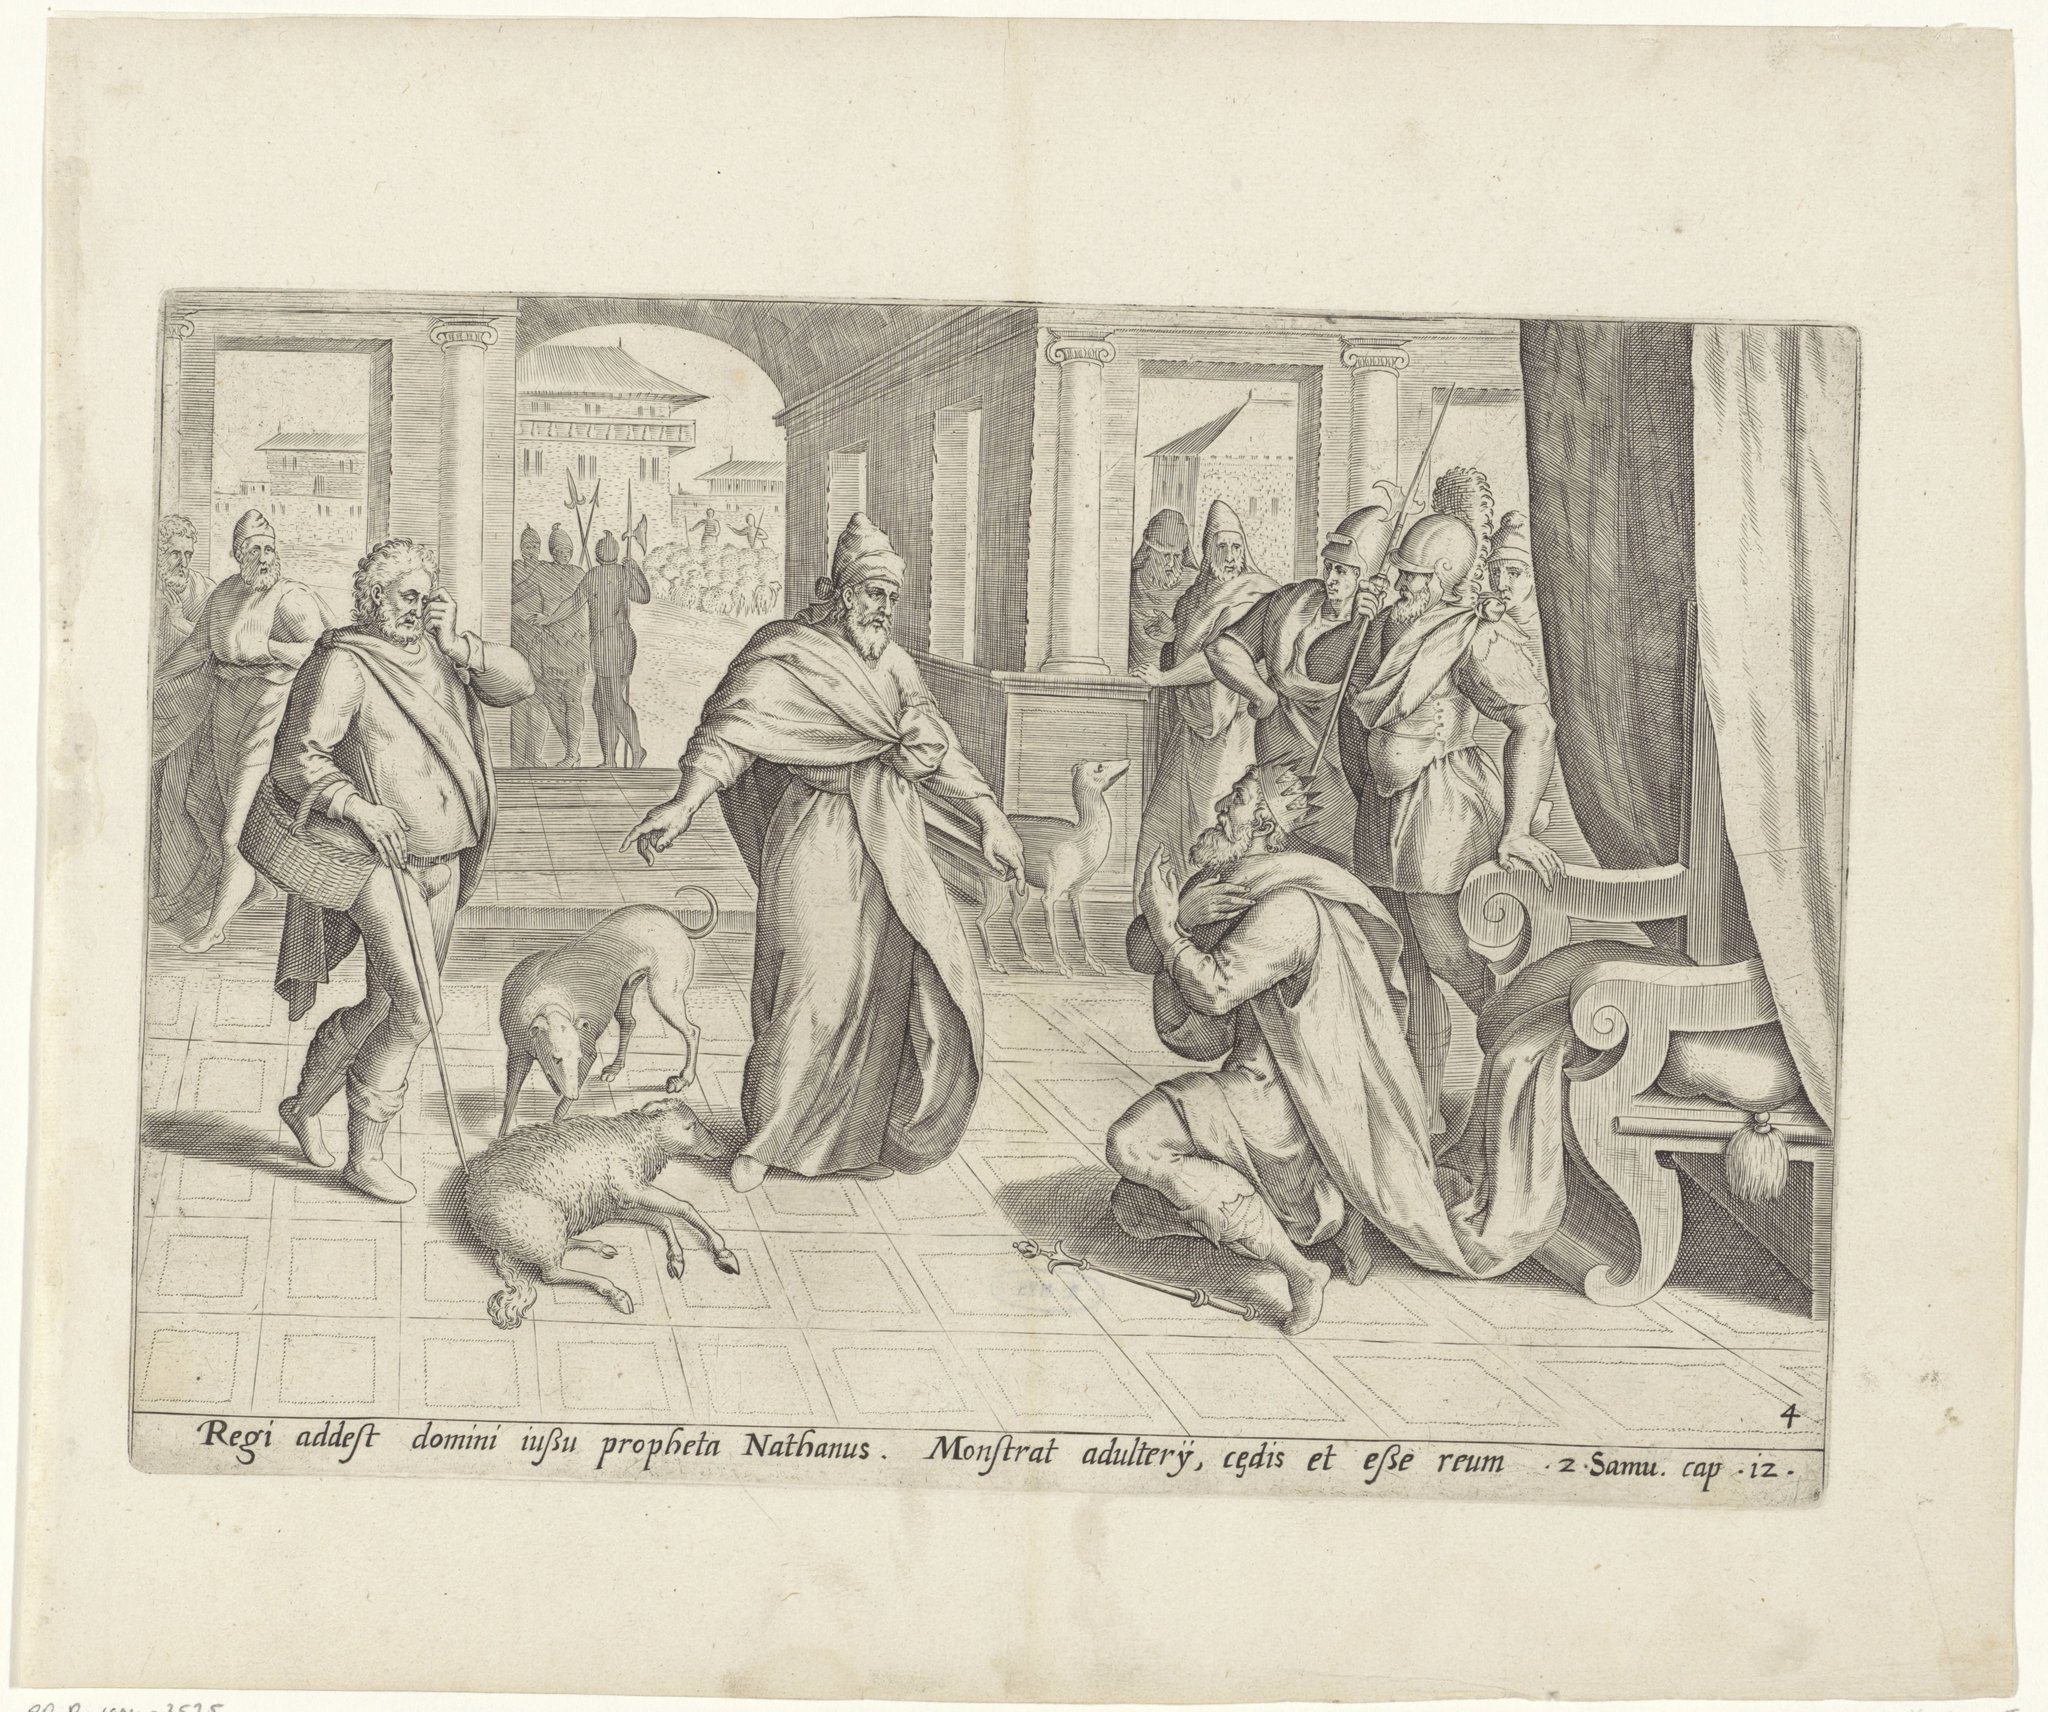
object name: print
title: Theatrum biblicum (...)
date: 1579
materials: paper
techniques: engraving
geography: amsterdam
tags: nathan's parable: the rich man takes the poor man's lamb to prepare it for his guest, david rebuked by nathan, lamb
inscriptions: collector's mark: Lugt 2228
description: De profeet Natan komt bij koning David en vertelt hem een parabel over een rijke man, die het lam van een arme man afpakte en het slachtte. Natan wijst daarbij op de arme man en het gestorven lam naast zich. Met deze parabel vertelt Natan dat David heeft gehandeld zoals de rijke man. David knielt en erkent dat hij gezondigd heeft door overspel te plegen met Batseba en haar man Uria te laten doden. Onder de voorstelling een verwijzing in het Latijn naar de Bijbeltekst in 2 Sam. 12.